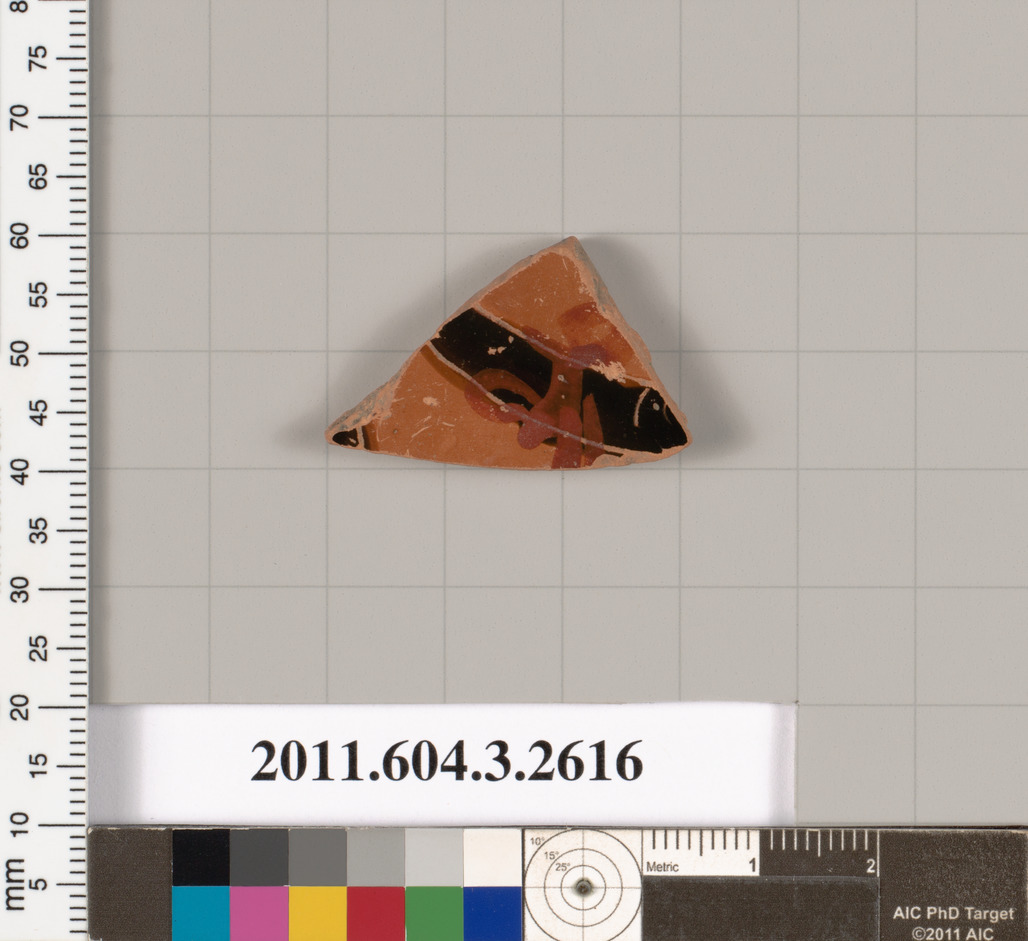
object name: kylix fragment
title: Terracotta fragment of a kylix (drinking cup)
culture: greek, attic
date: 550-501 BCE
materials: terracotta